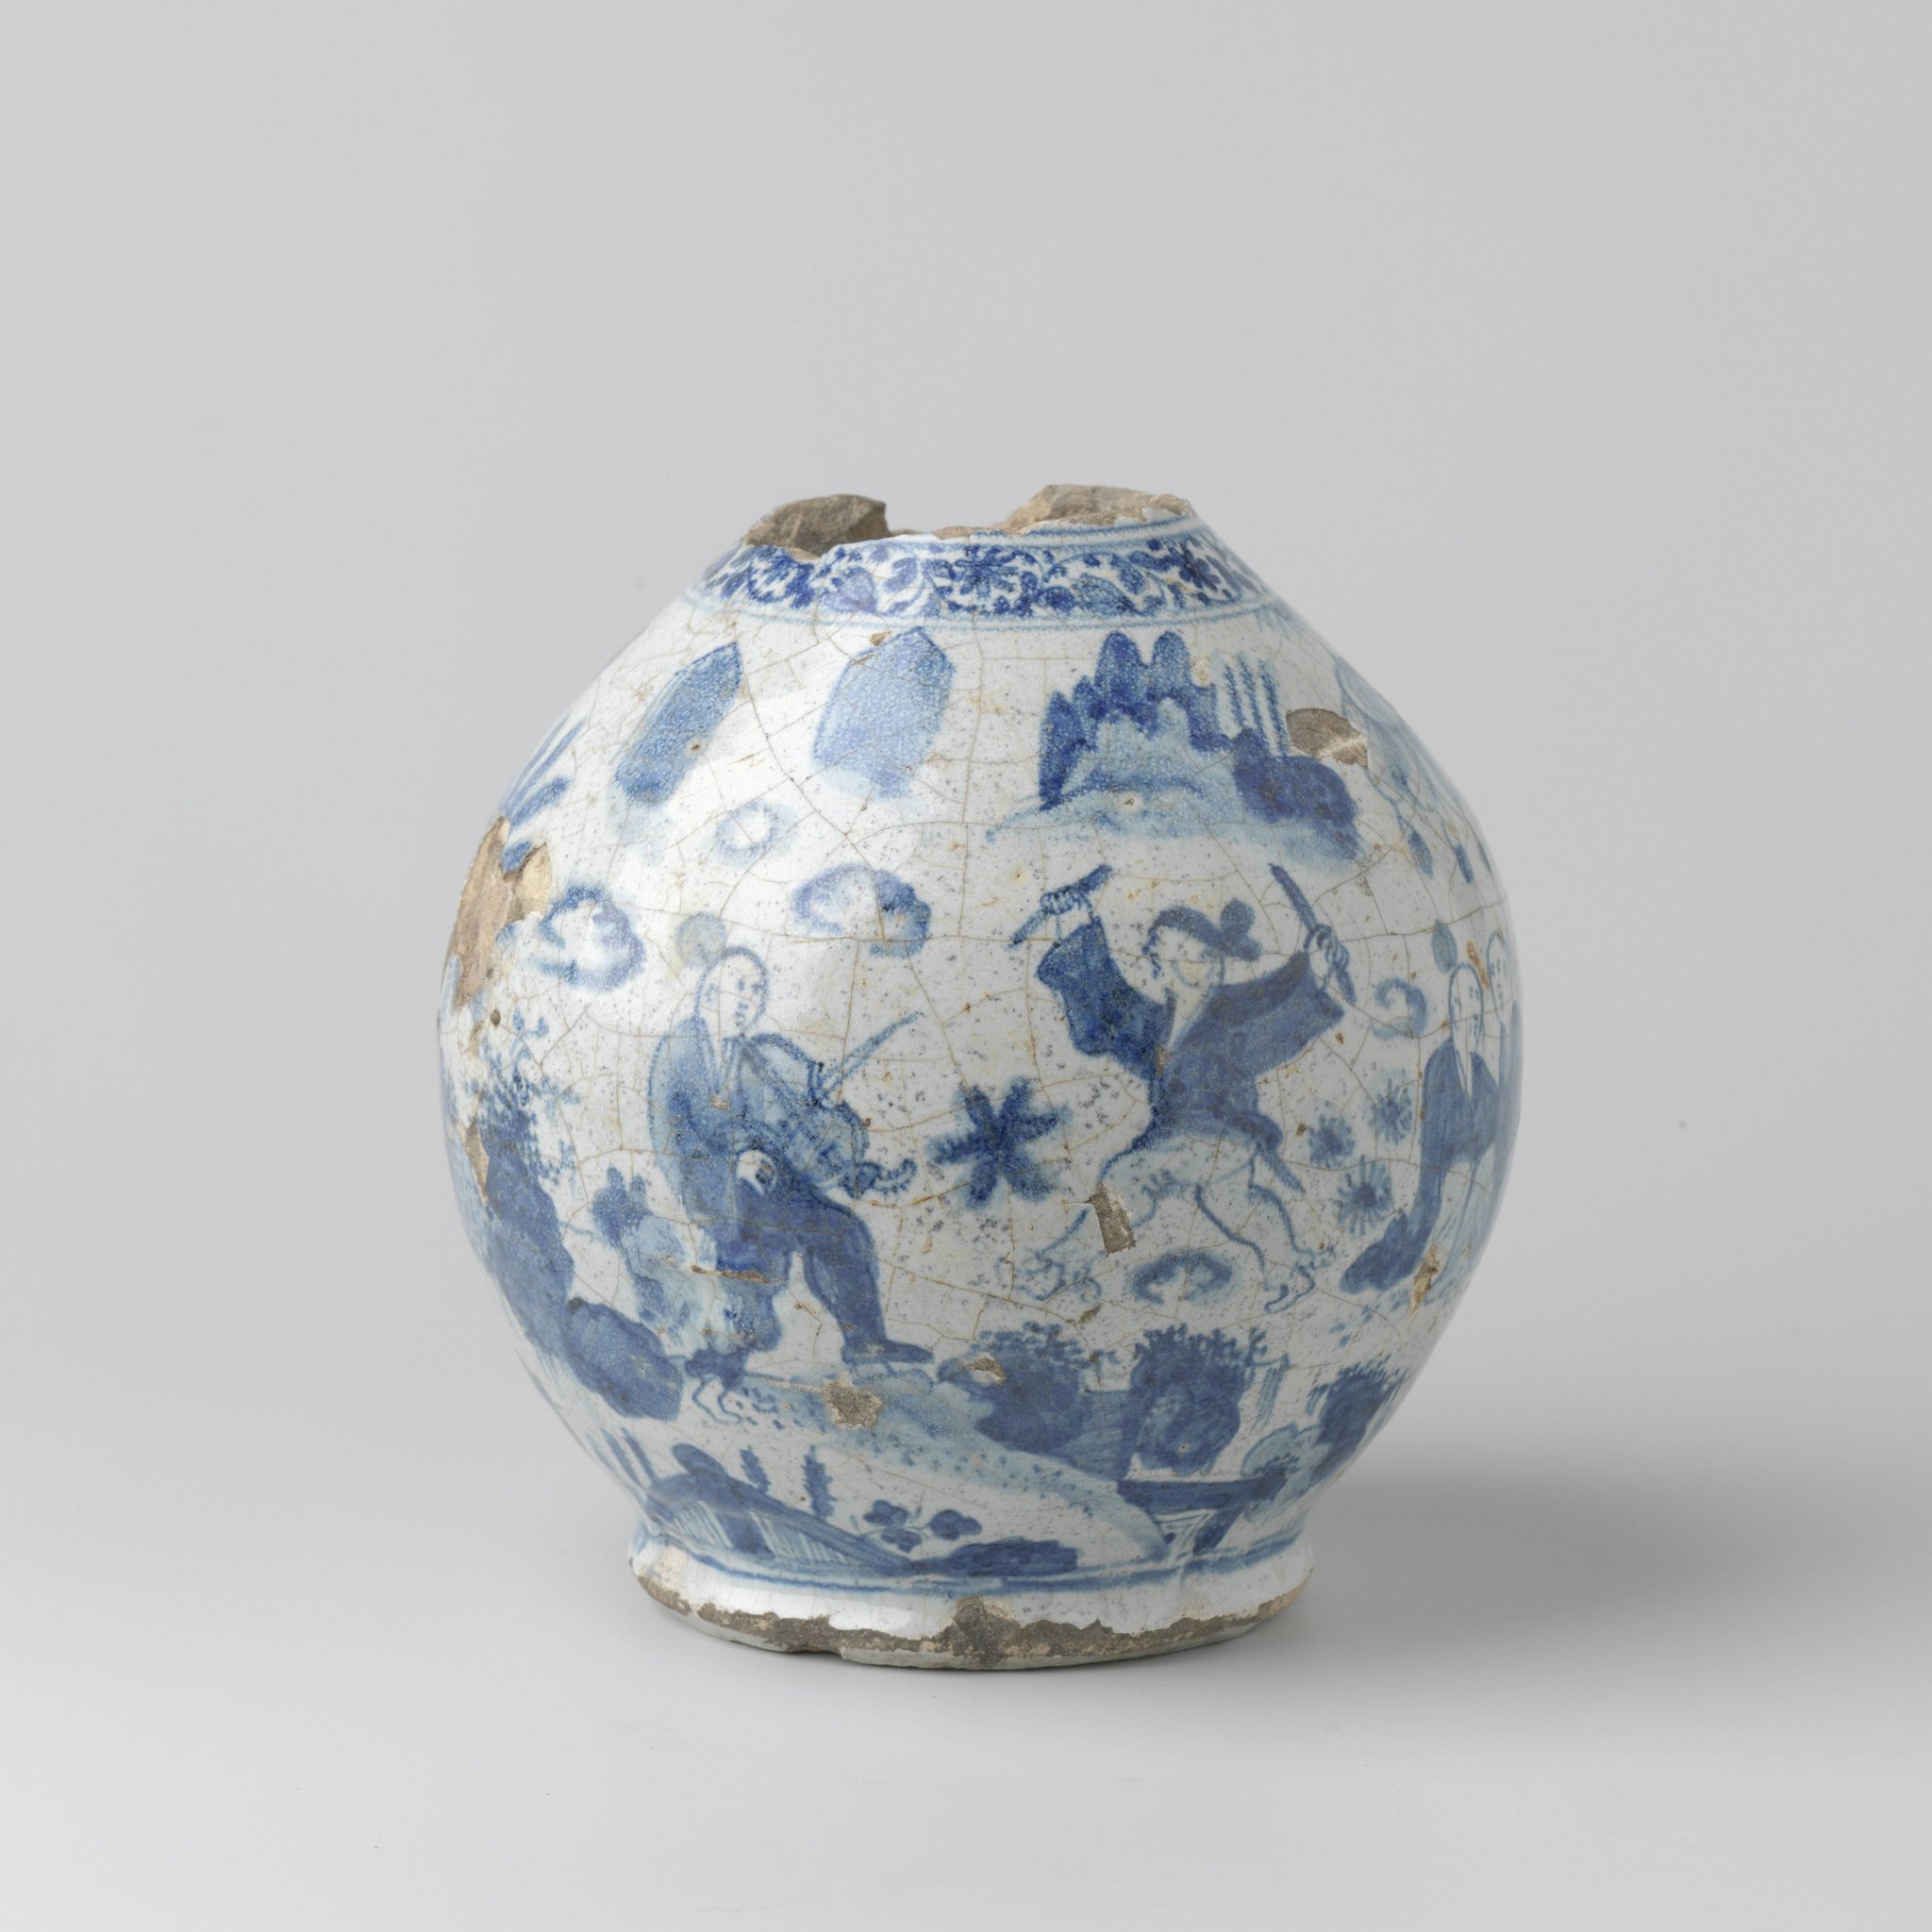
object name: vase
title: Vaas, bolvormig, beschilderd in blauw met landschap met Chinese figuren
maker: Anonymous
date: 1630-1650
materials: earthenware, glaze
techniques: maiolica, painted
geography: netherlands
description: Bolvormige vaas van blauw beschilderde majolica. De hals van de vaas ontbreekt. Op de vaas is een landschap geschilderd met Chinese figuren. Een figuur speelt viool, een danst, drie zitten onder een scherm, drie wandelen met een vlag en twee zitten op een bank. De vaas is een bodemvondst.